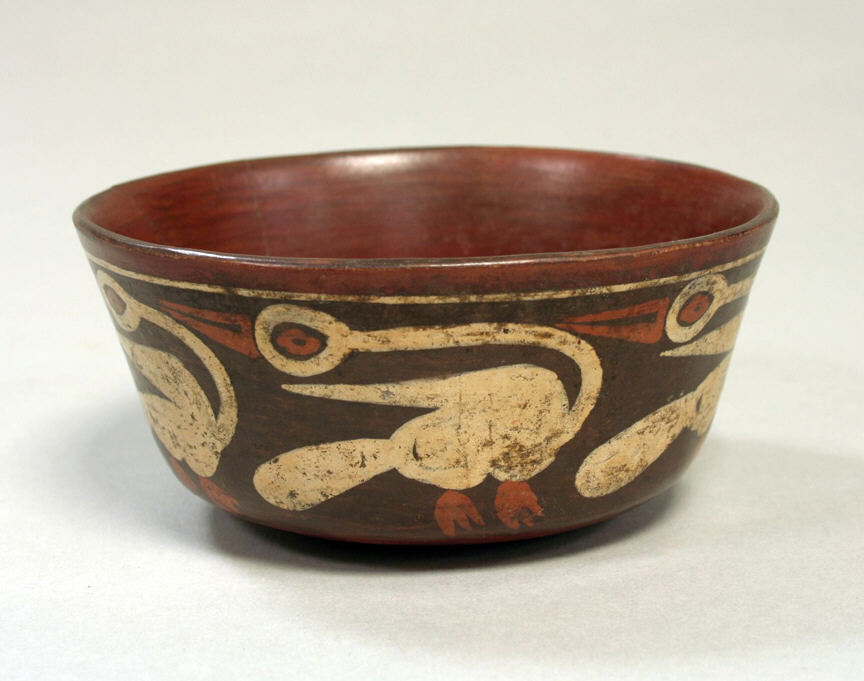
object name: bowl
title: Painted Bowl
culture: nasca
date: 1-600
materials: ceramic, pigment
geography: peru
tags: birds